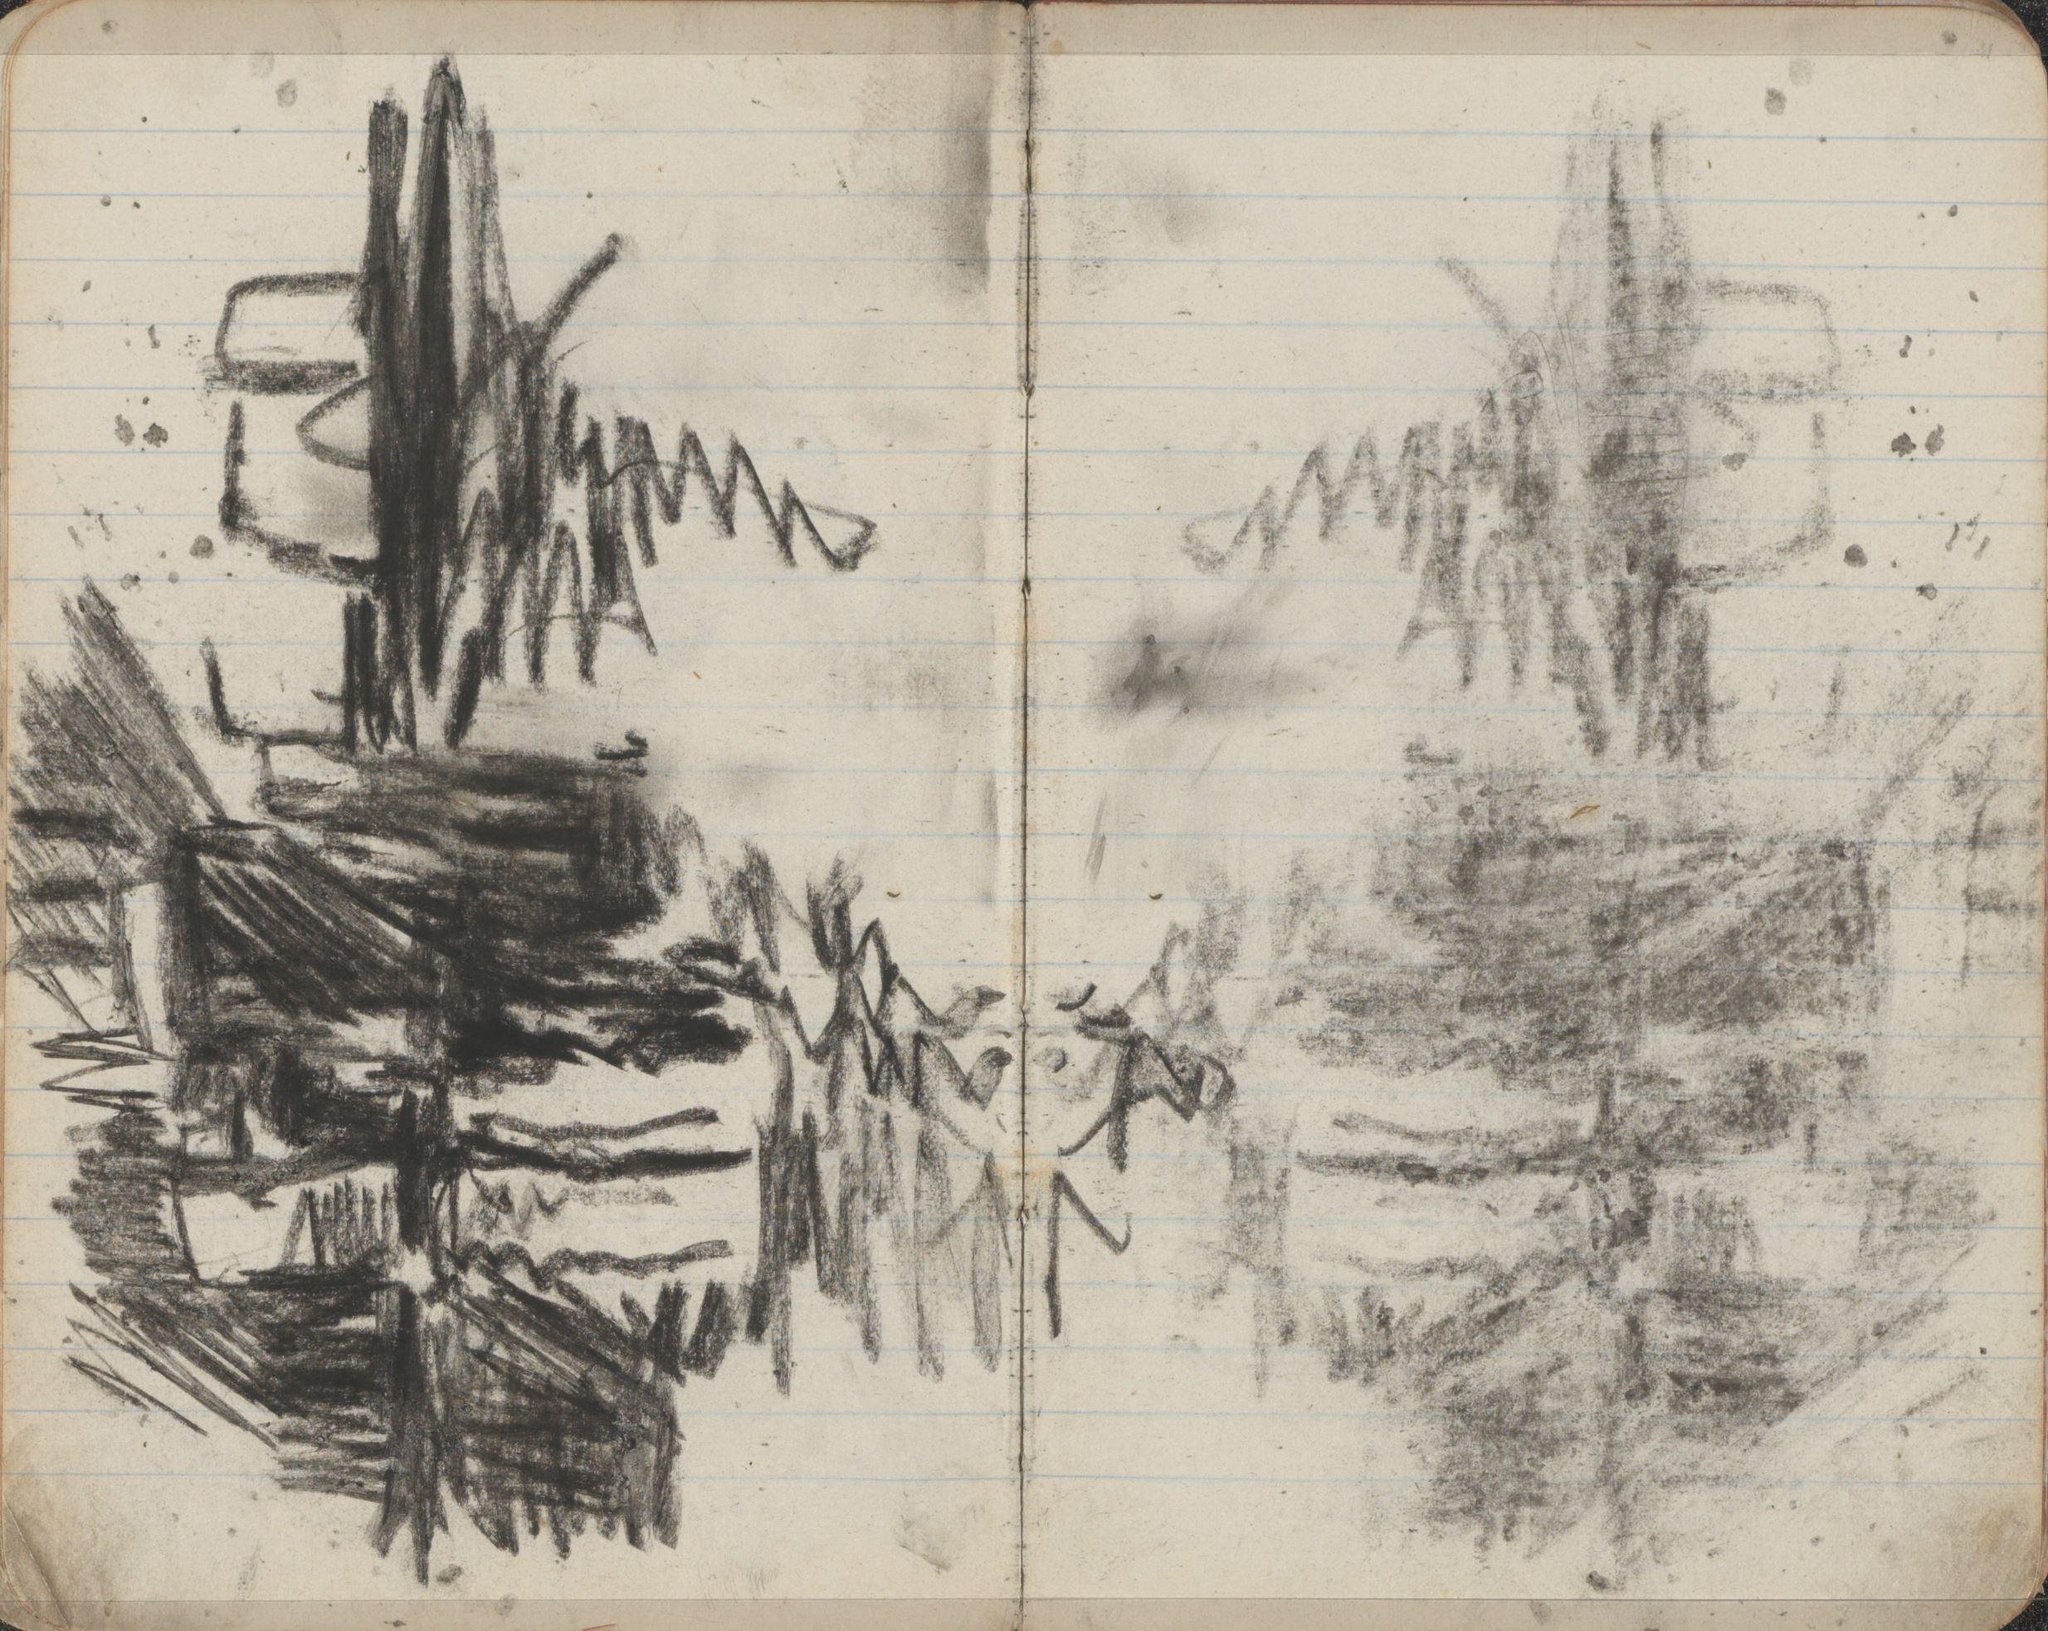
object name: sketchbook leaf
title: Paardentrams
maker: george hendrik breitner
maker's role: draughtsman, painter, print maker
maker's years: 1857-1923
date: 1893-1894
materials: chalk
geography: amsterdam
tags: diligence, omnibus, horse-tram, horse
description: Pagina 10 en pagina 11 uit een schetsboek met 36 bladen.